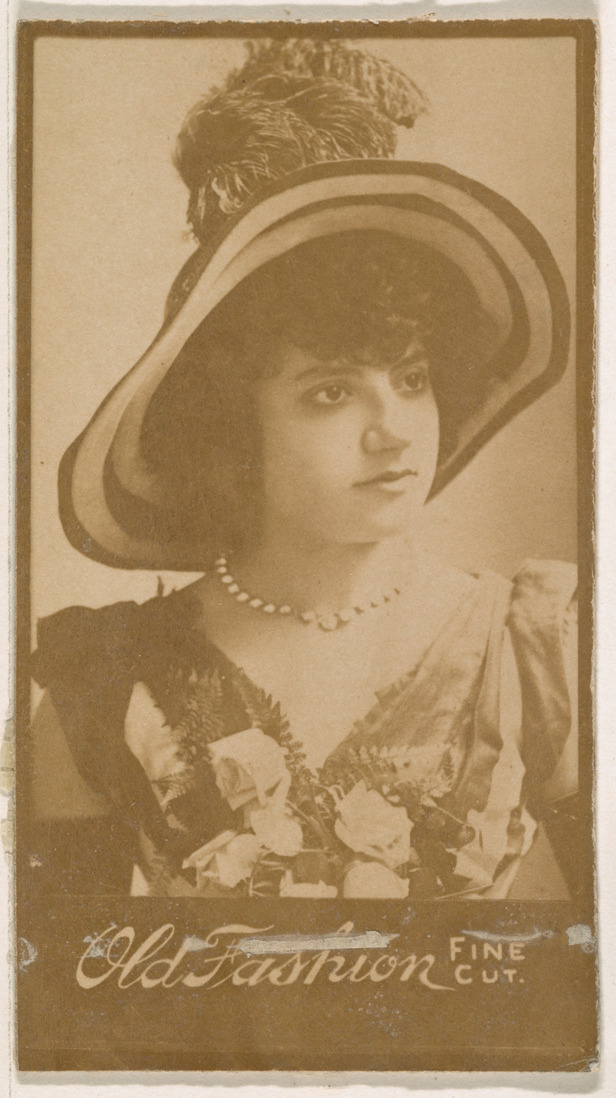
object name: photograph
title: Actress wearing wide-brimmed hat with feathers, from the Actresses series (N664) promoting Old Fashion Fine Cut Tobacco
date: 1888-1890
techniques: albumen silver print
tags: portraits,women,actresses